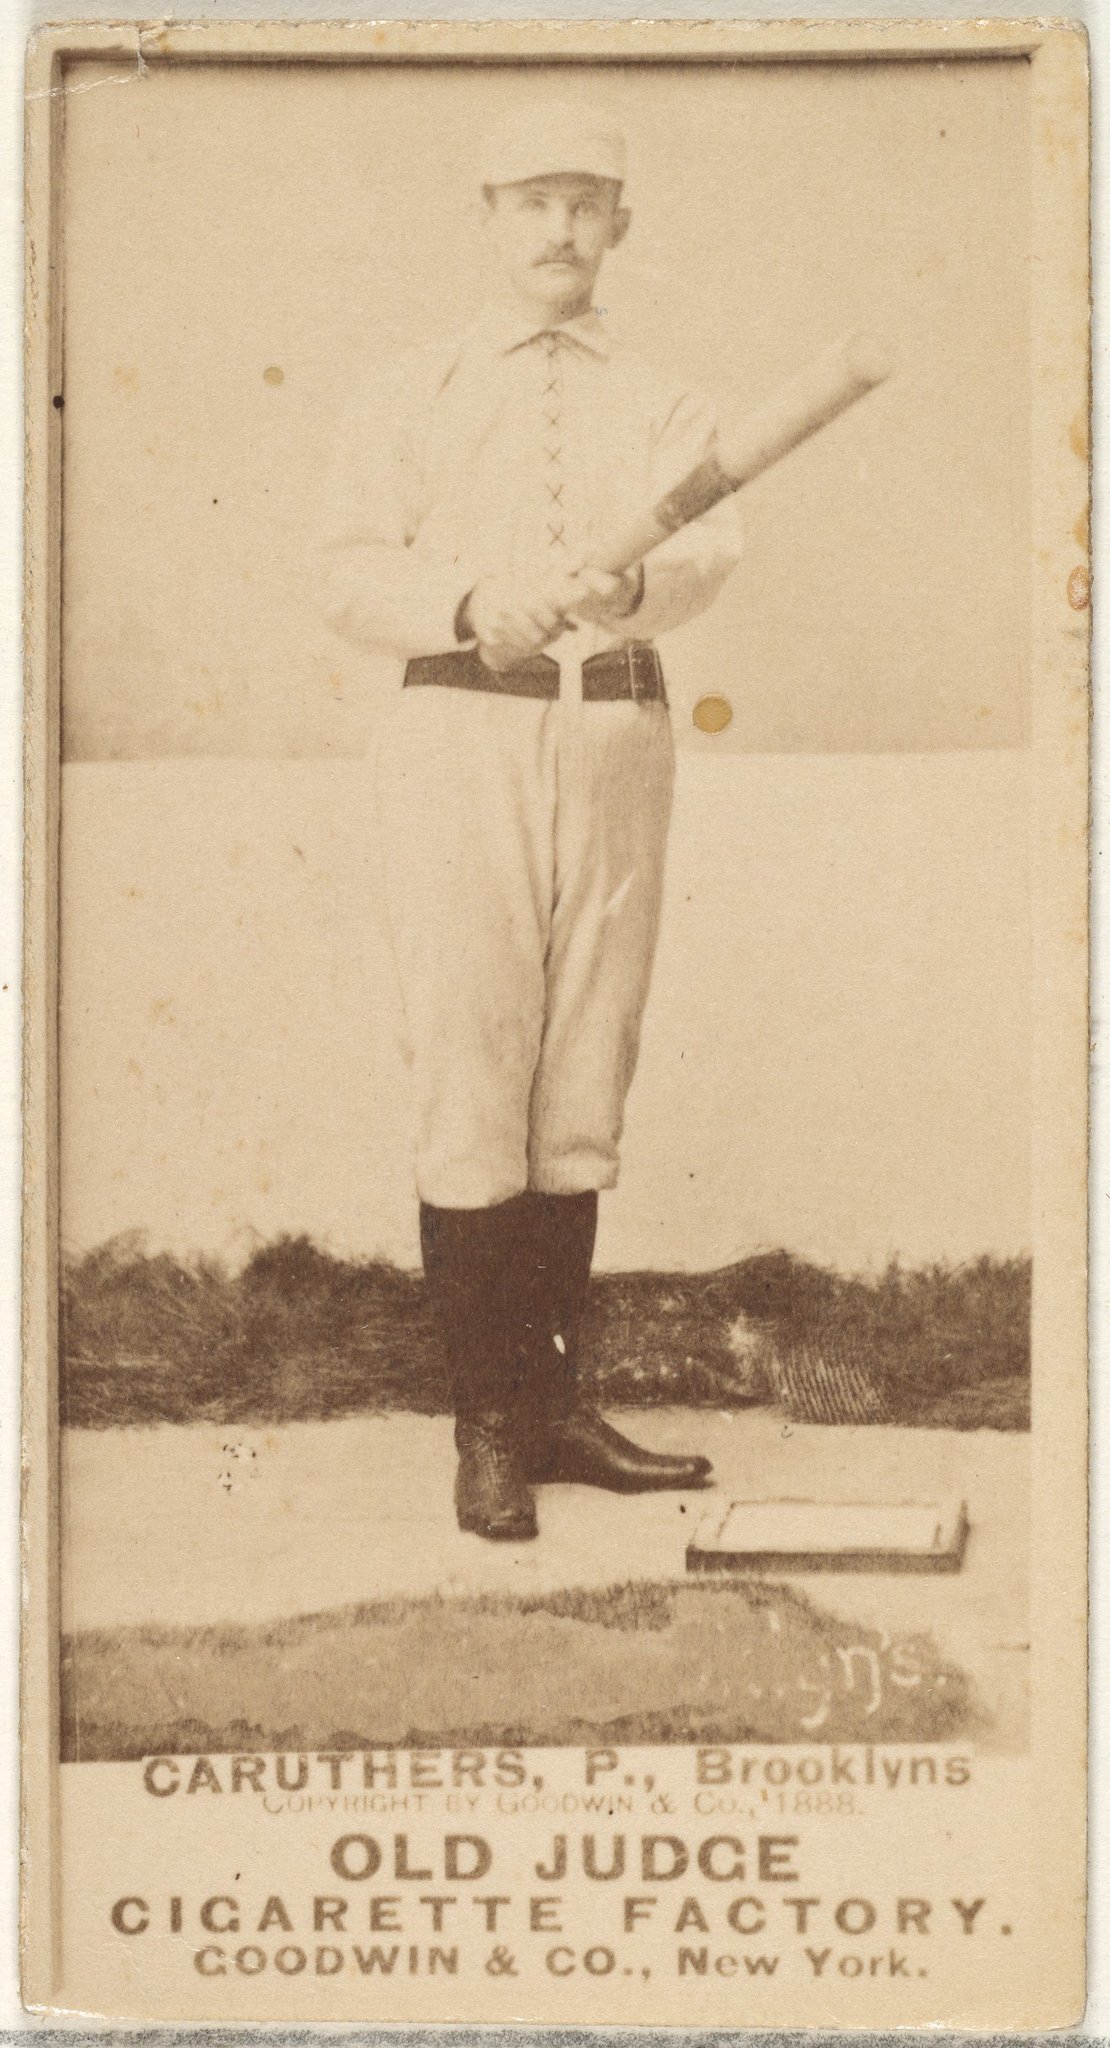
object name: baseball card, photograph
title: Caruthers, Pitcher, Brooklyn, from the Old Judge series (N172) for Old Judge Cigarettes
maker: goodwin & company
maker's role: publisher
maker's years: 1850-1950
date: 1888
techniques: albumen silver print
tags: men,portraits,baseball,athletes